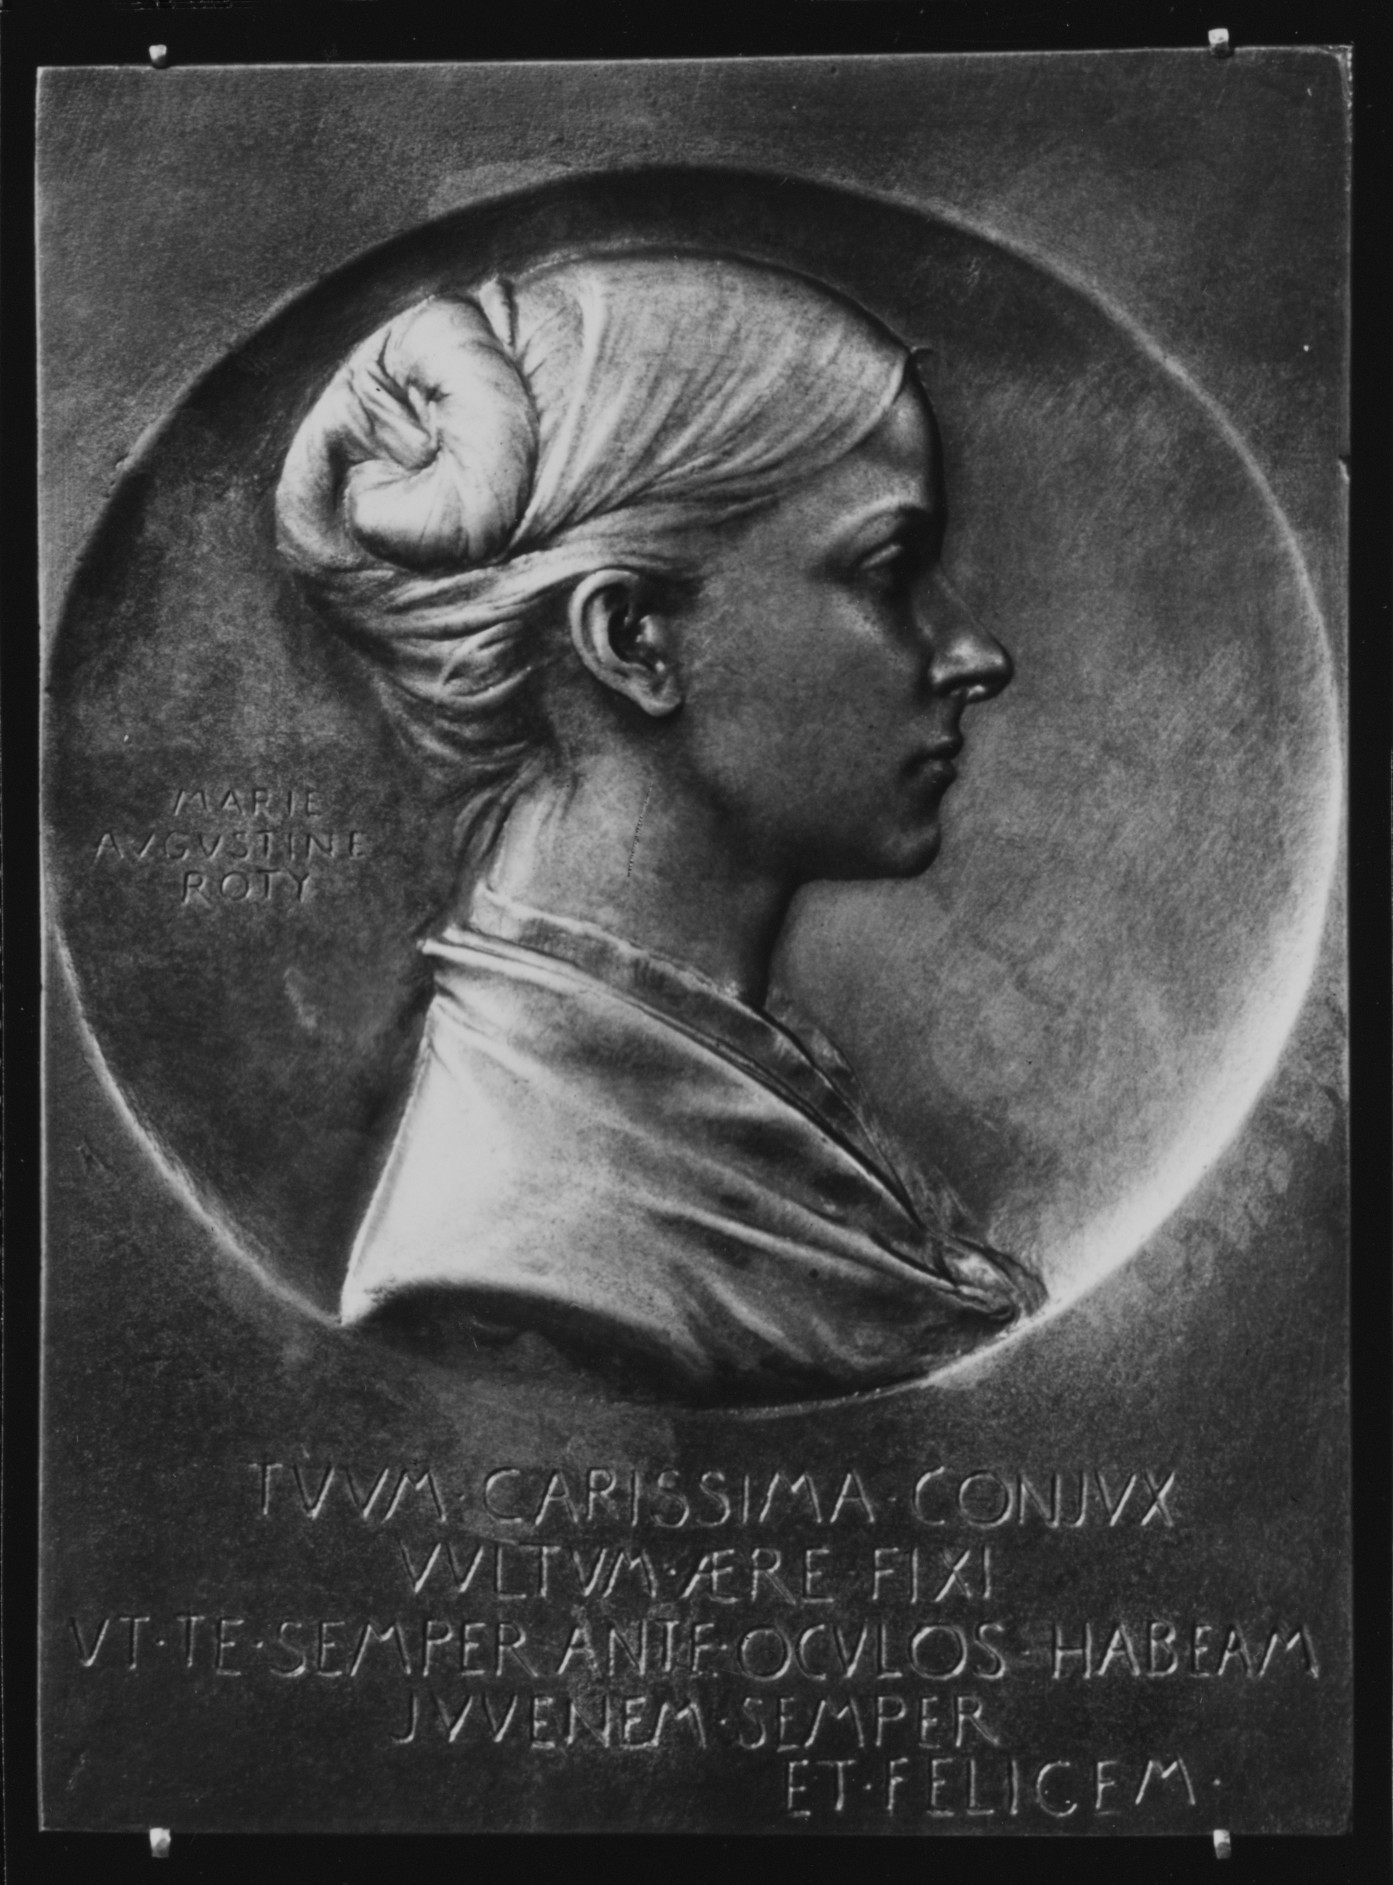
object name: plaquette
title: Marie Augustine Roty, Wife of the Medalist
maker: louis-oscar roty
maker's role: artist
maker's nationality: french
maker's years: 1846-1911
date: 1880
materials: bronze, patina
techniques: casting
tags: profiles,women